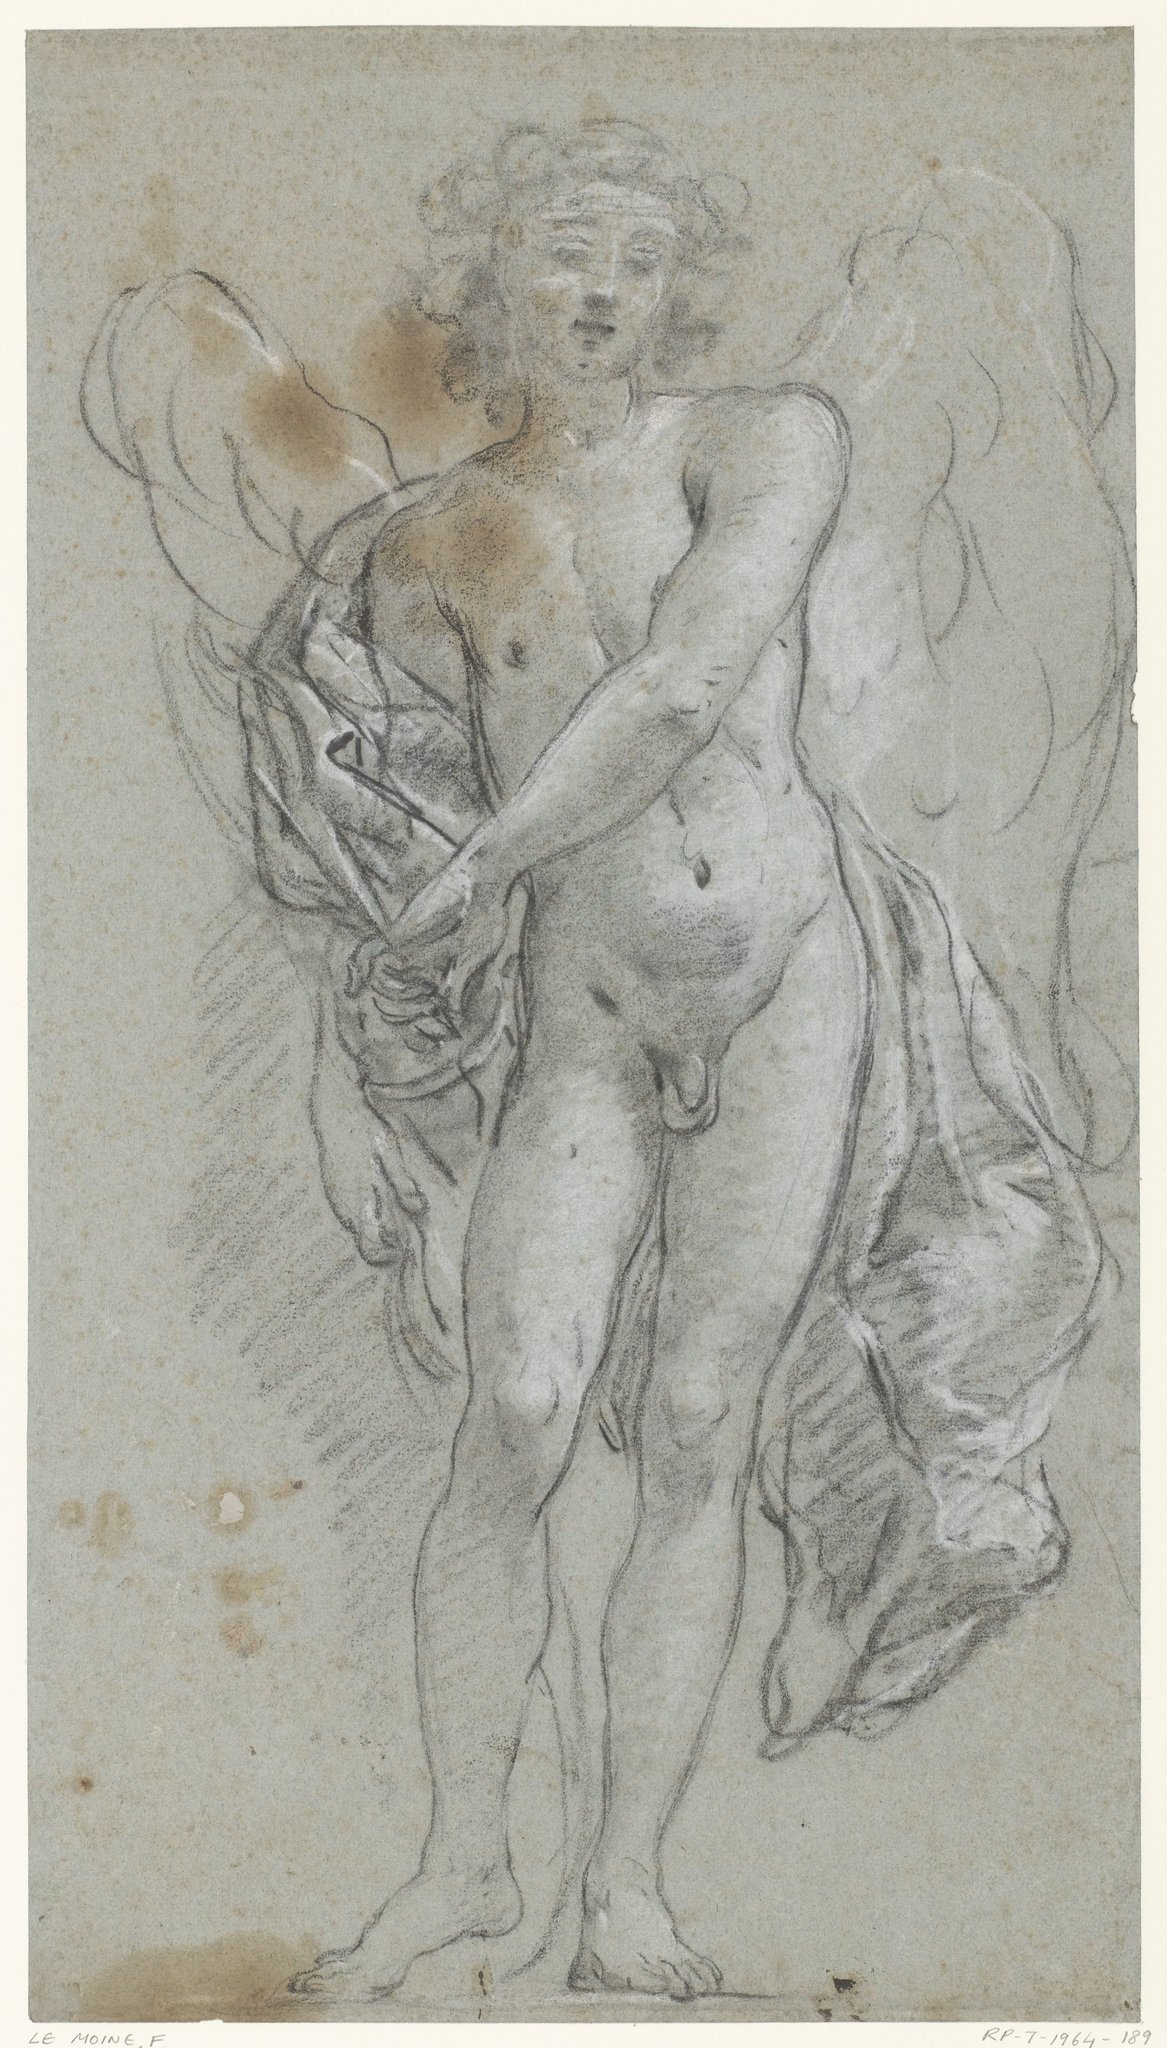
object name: design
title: Staande Eros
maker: françois le moine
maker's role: draughtsman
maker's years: 1688-1737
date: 1714-1778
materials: chalk, paper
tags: standing figure, (story of) cupid, amor (eros)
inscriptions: annotation, verso, lower right, pencil: ‘Lemoyne’